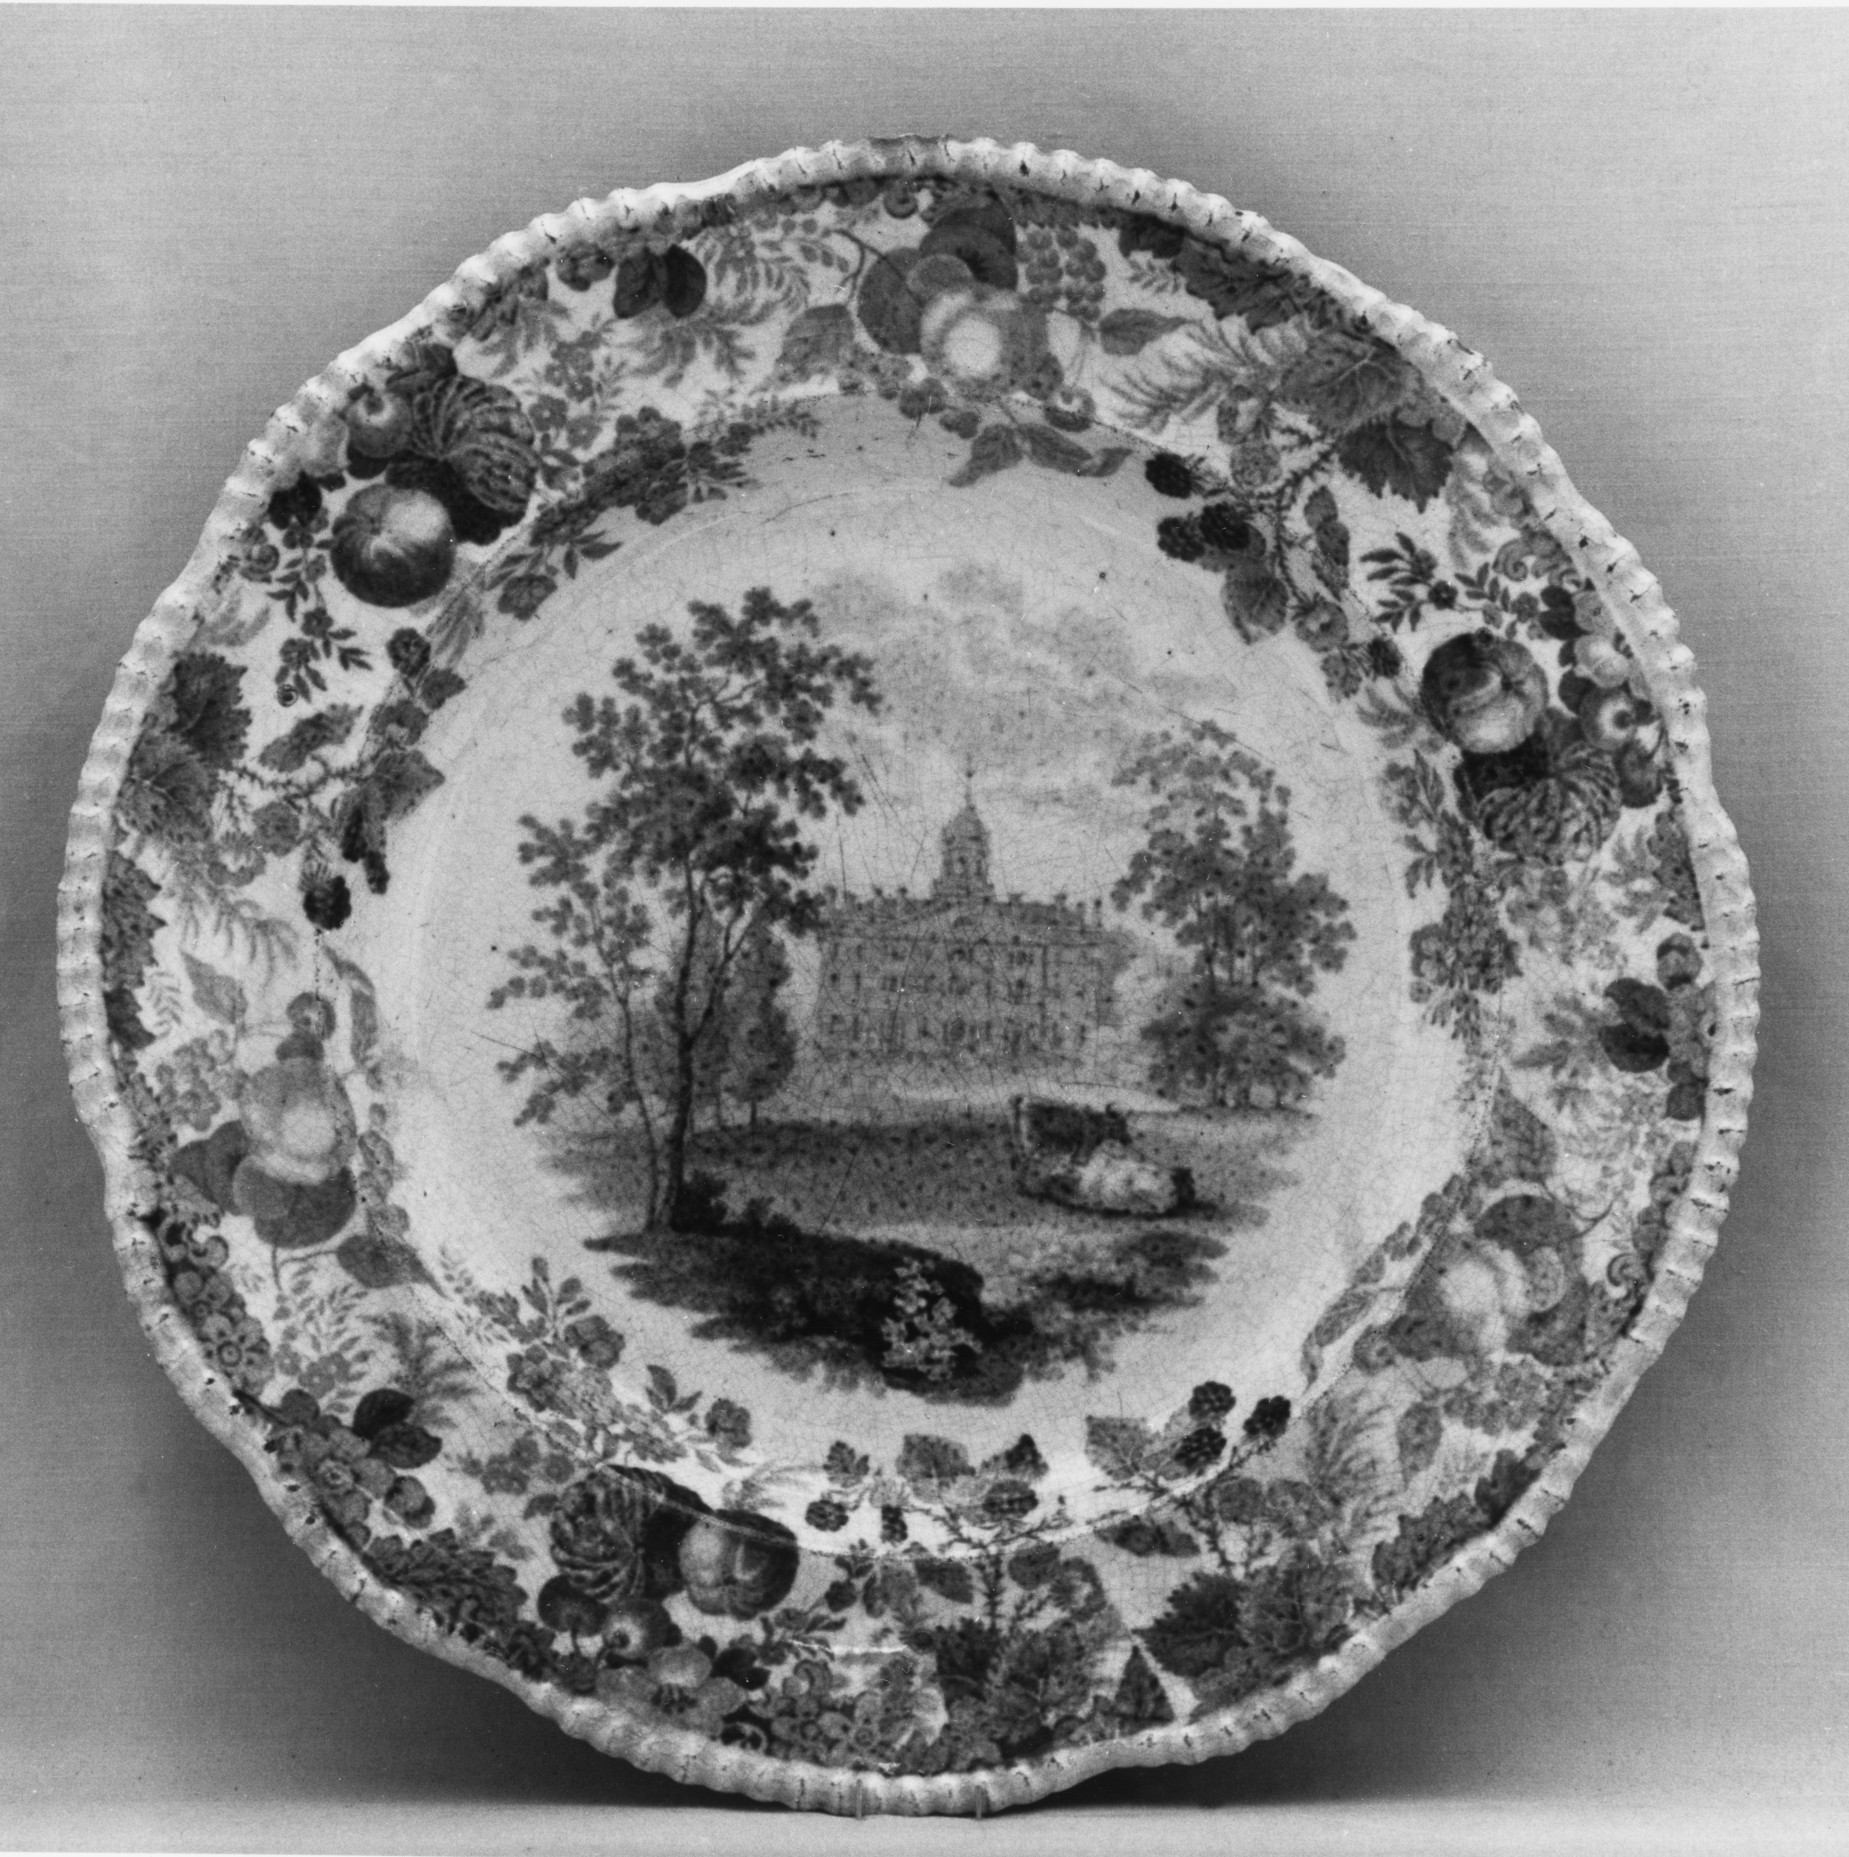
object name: plate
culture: british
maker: enoch wood & sons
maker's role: maker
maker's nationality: british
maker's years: 1818-1846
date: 1828-1846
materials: earthenware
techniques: transfer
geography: england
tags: buildings,trees